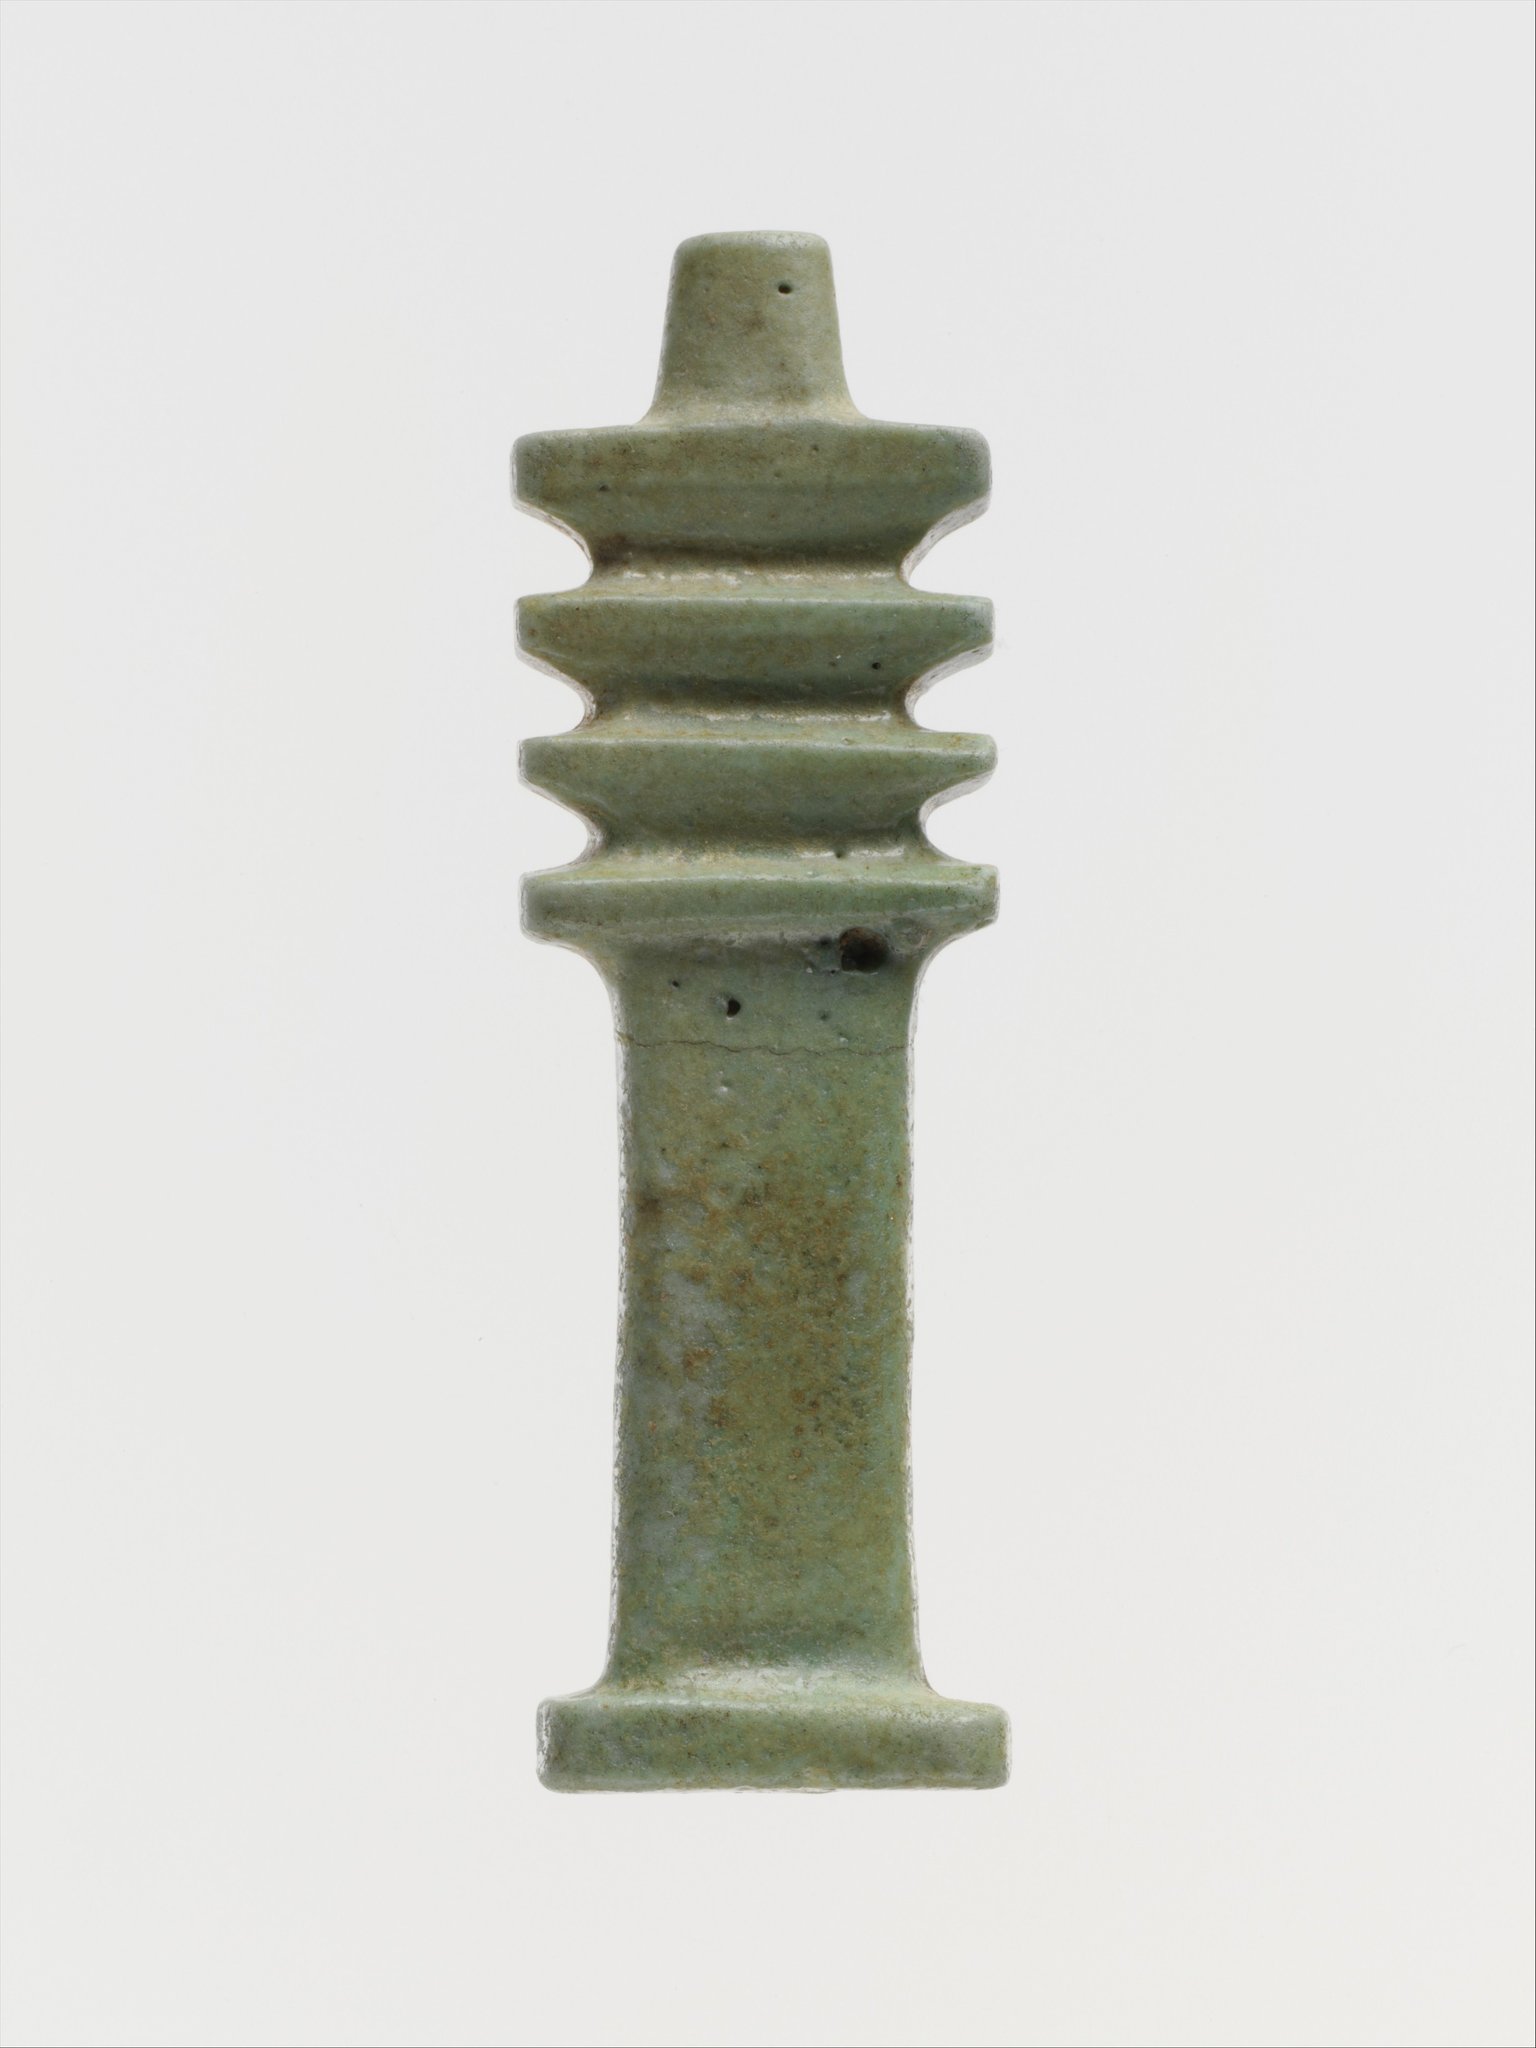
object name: amulet pendant, djed sign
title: Faience djed-pillar amulet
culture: egyptian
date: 664-630 BCE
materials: faience